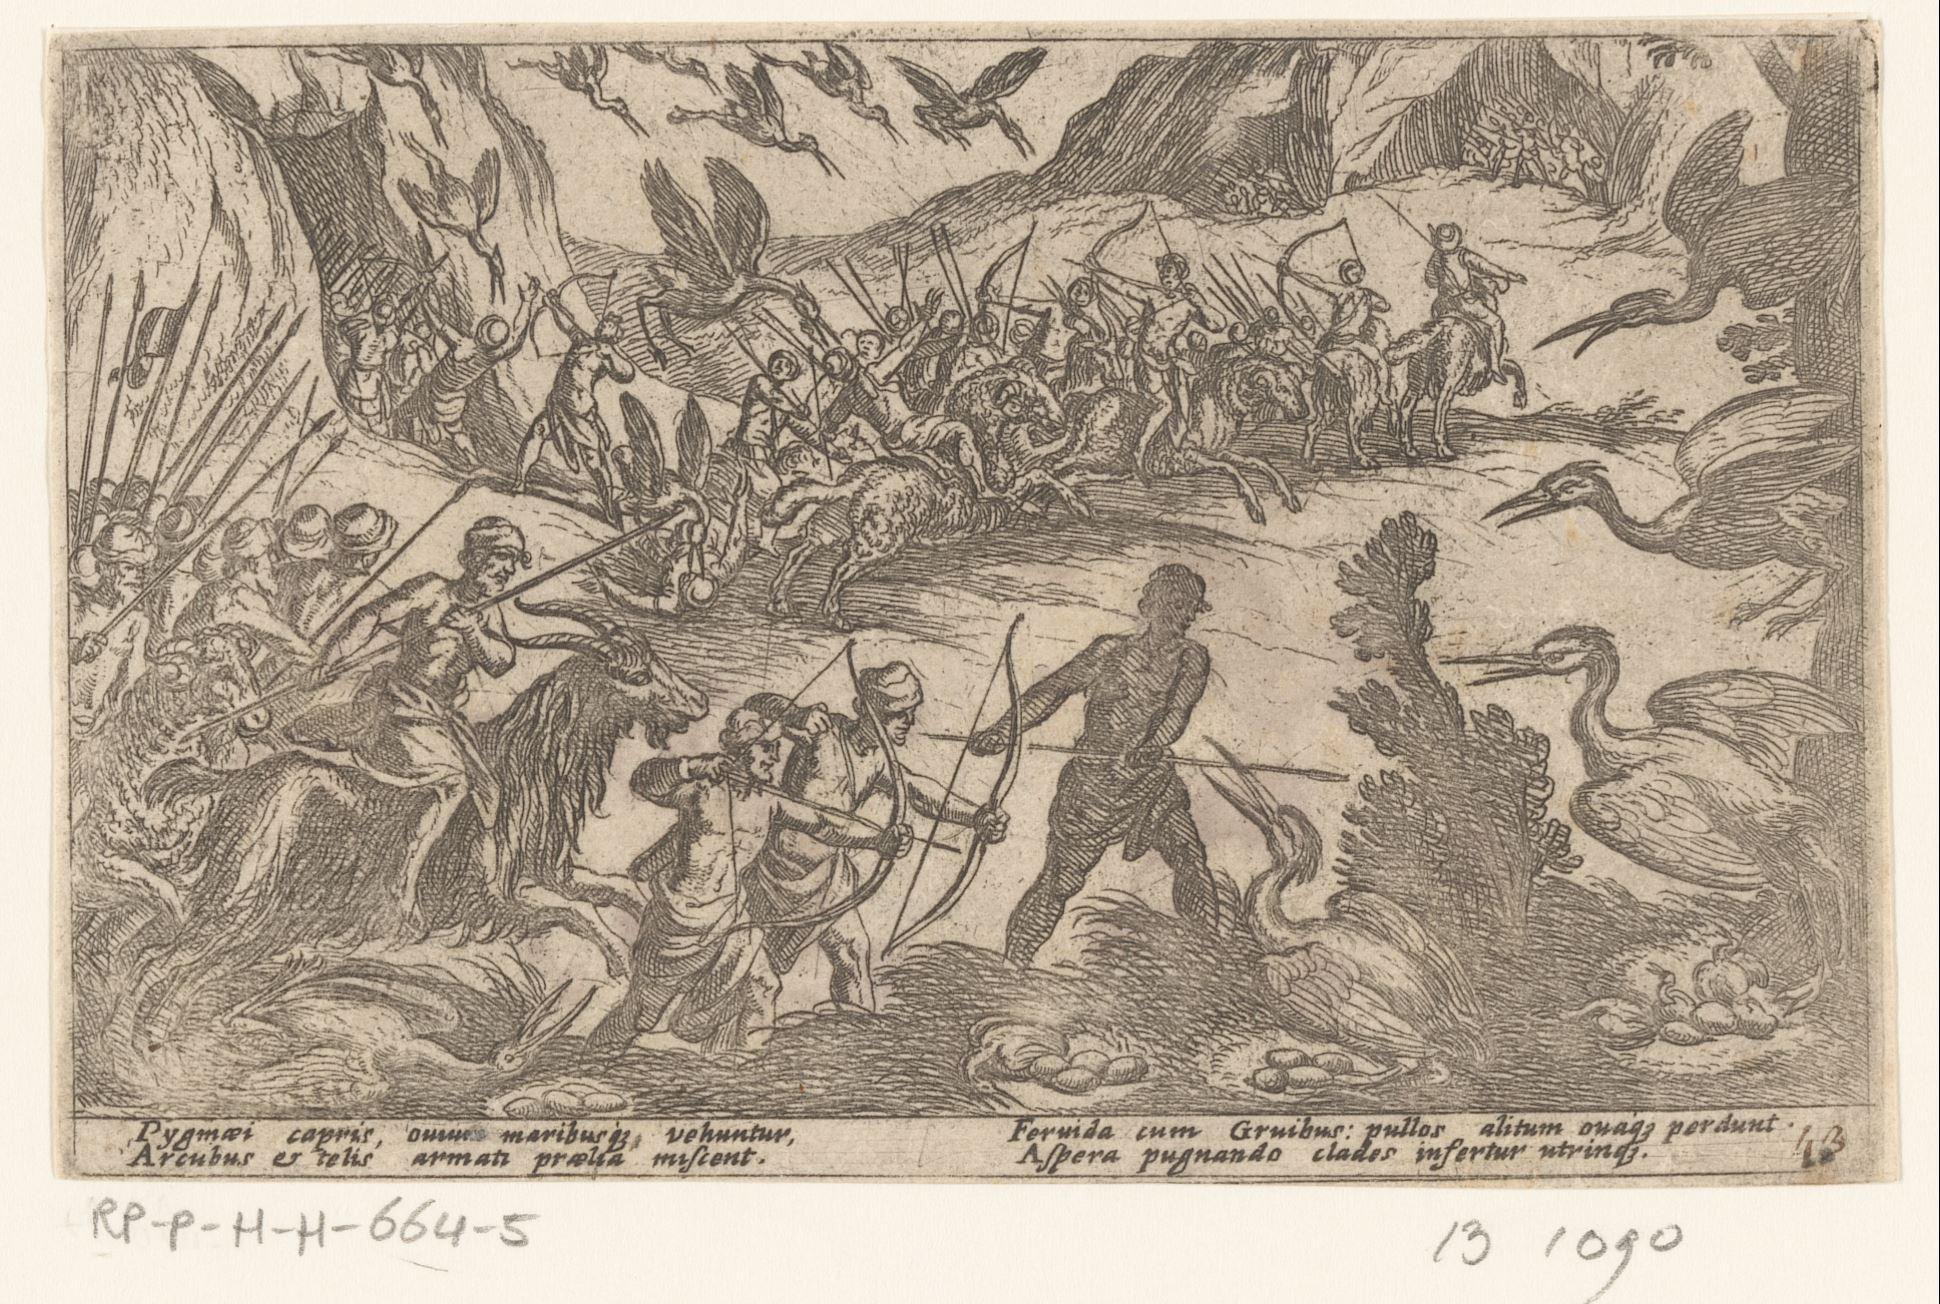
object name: print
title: Diverse jacht- en strijdscènes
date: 1605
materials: paper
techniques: etching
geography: rome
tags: shore-birds and wading-birds: crane, hunter, hunters hunting (n.b.: in 1988-1990 this notation denoted the concept of 43c11421 'hunters resting during the hunt')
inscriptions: collector's mark: ‘Hinloopen’, number: ‘43’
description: Een groep primitieve jagers in lendendoeken jaagt broedende kraanvogels in het nauw. Op de achtergrond vallen kraanvogels de jagers aan. Tekst in het Latijn in ondermarge.